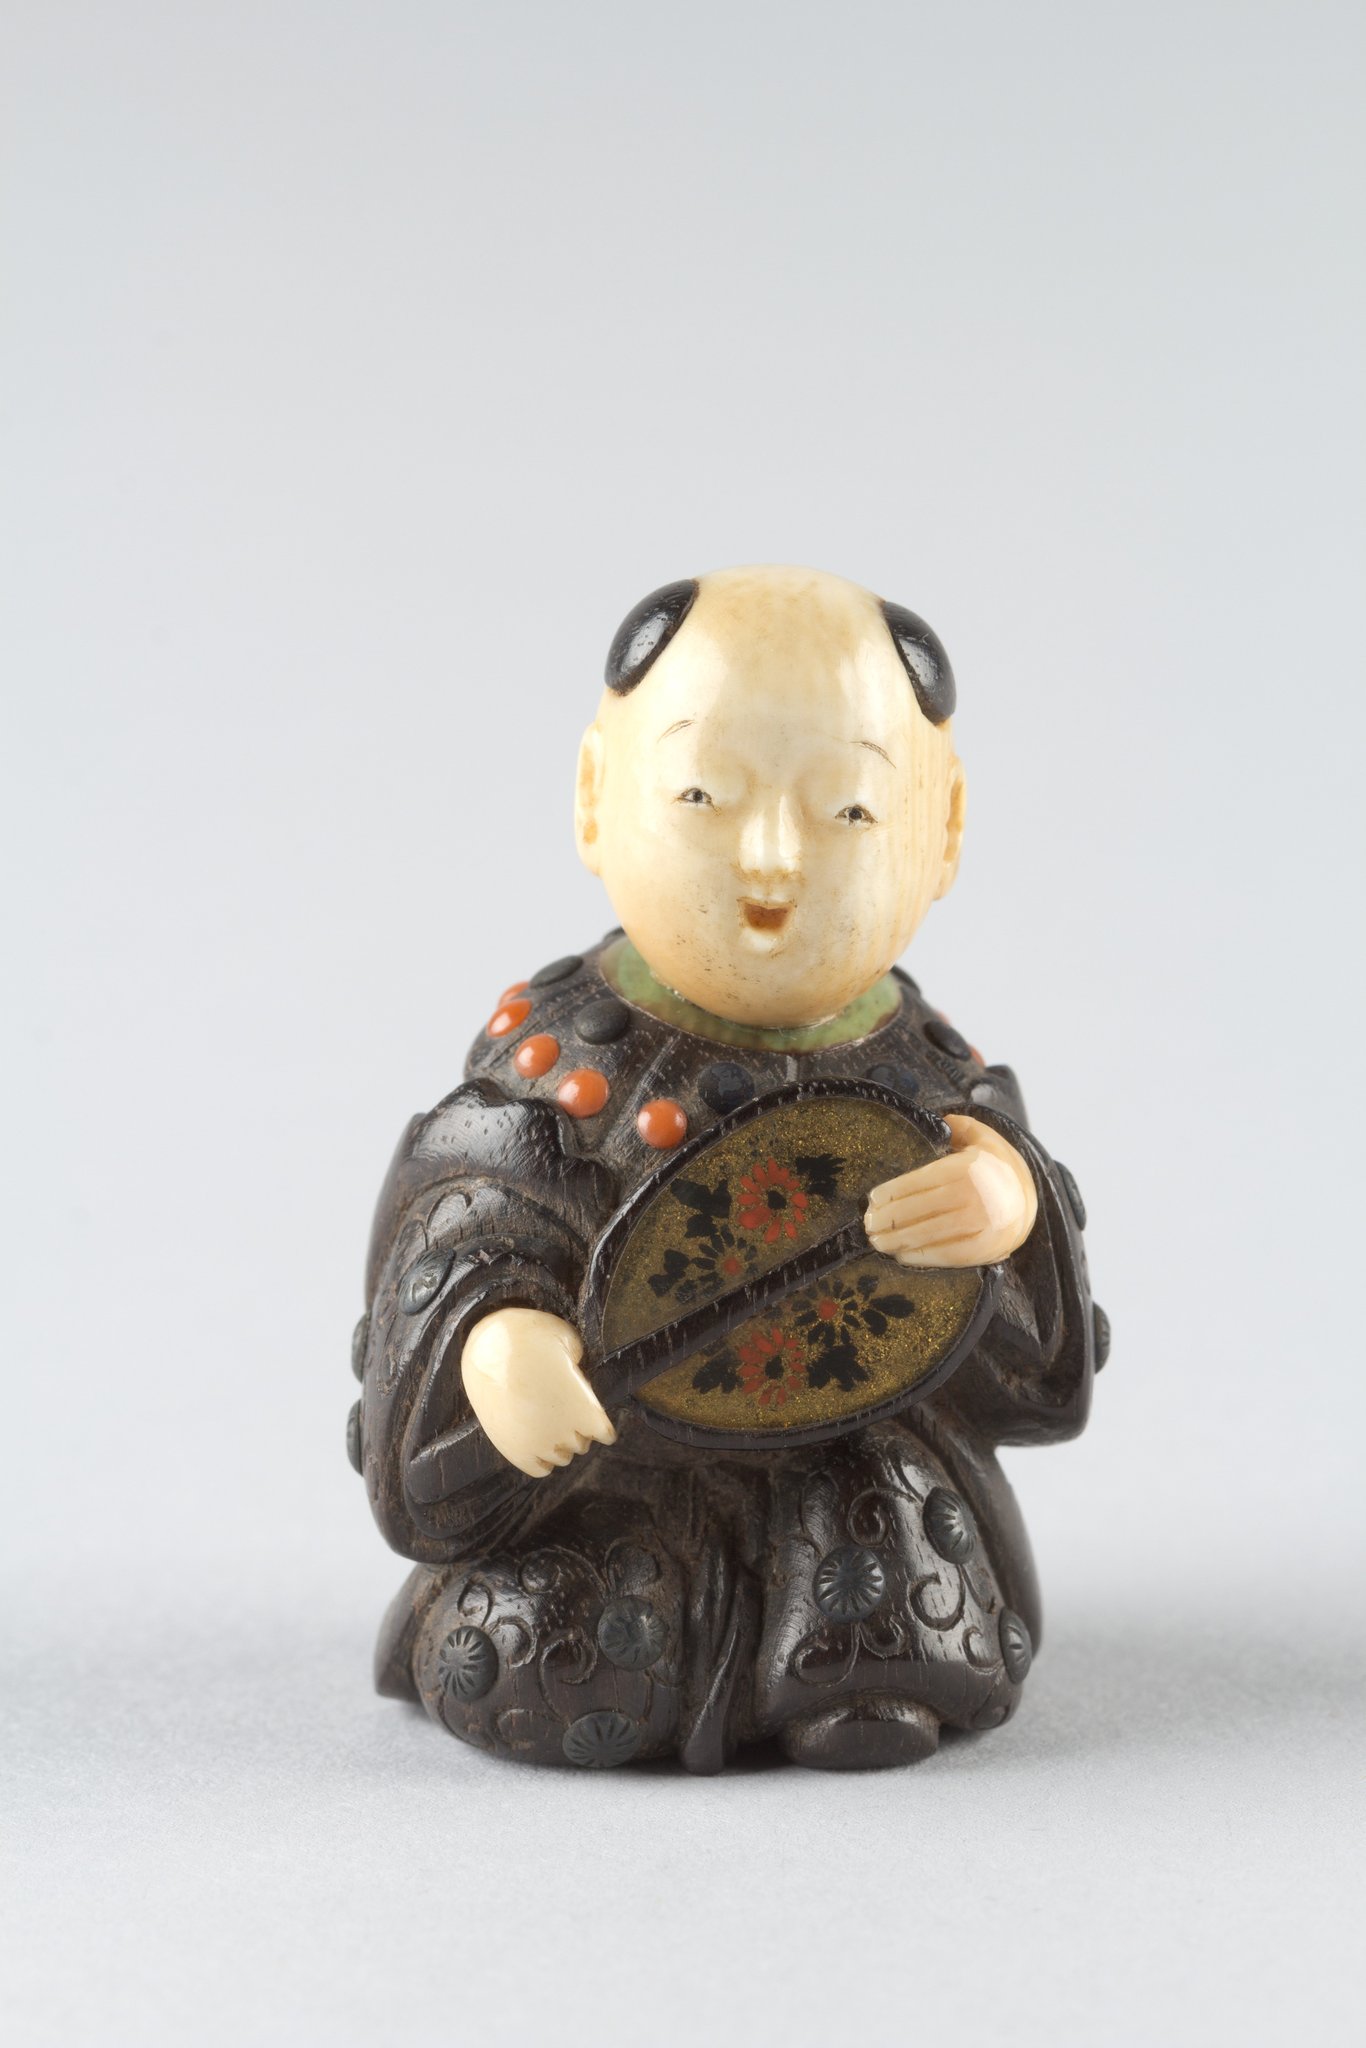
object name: netsuke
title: Netsuke of Boy with a Fan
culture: japanese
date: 1801-1900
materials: ivory, wood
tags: fans,boys